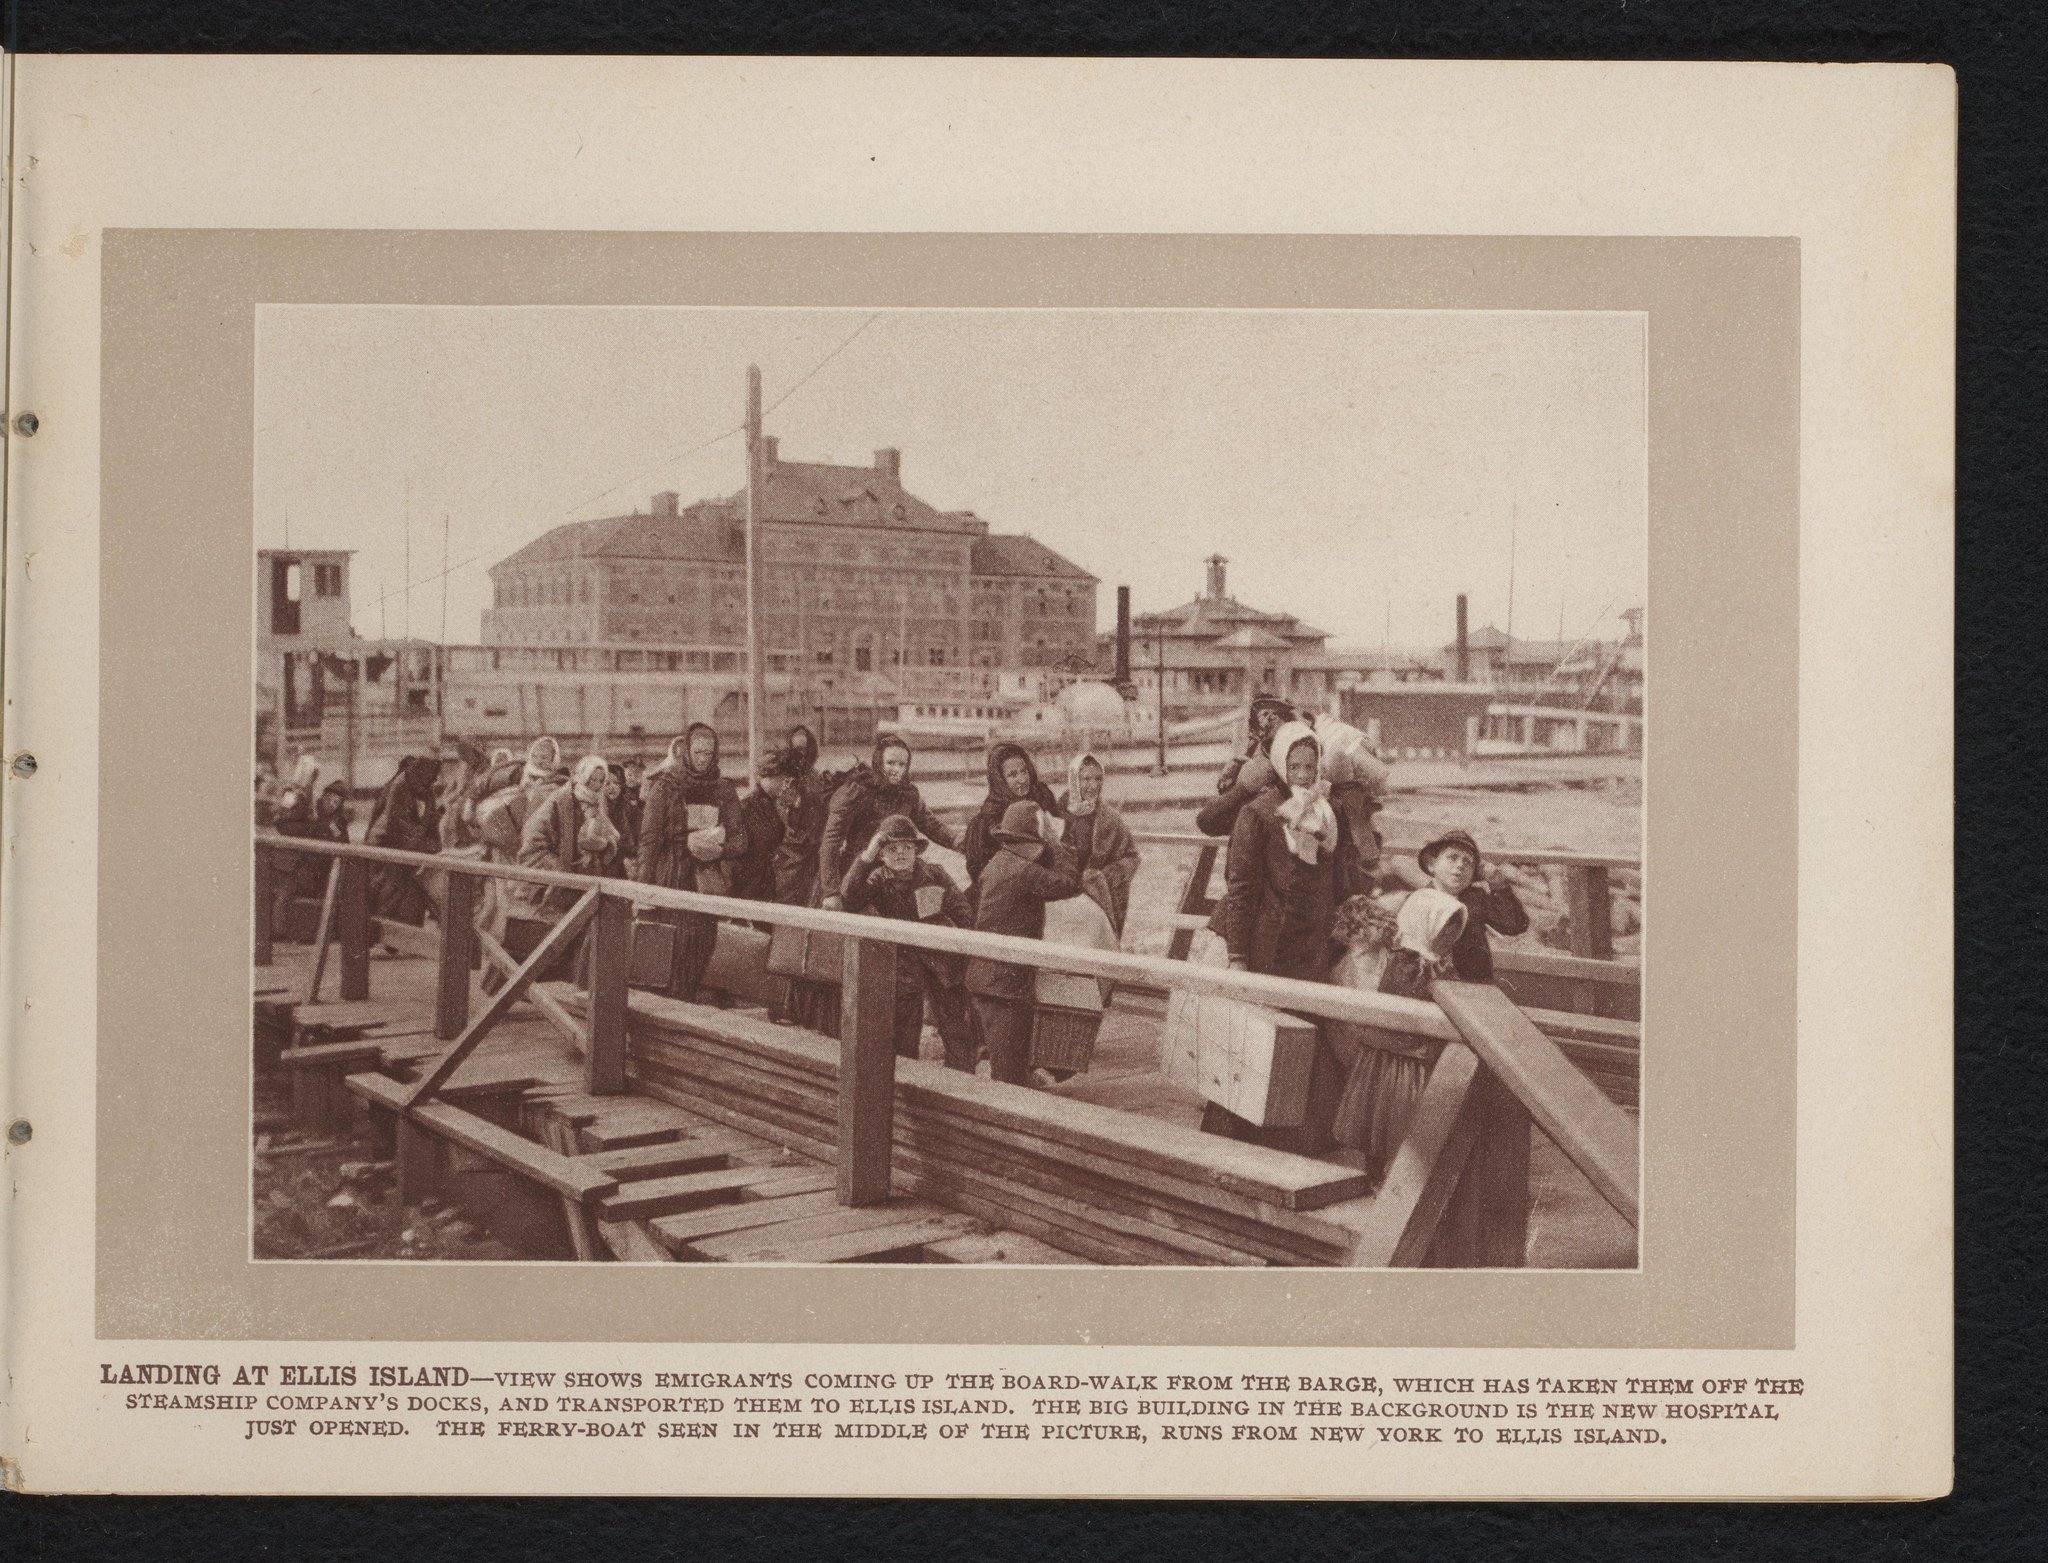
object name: photomechanical print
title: Landing at Ellis Island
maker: Anonymous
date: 1897-1902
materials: paper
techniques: autotype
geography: new york city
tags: institution for contagious diseases, (descendants of) european emigrants to america, pier, quay, wharf, historical persons not known by name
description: Prent op tweeëntwintigste ongenummerde pagina.